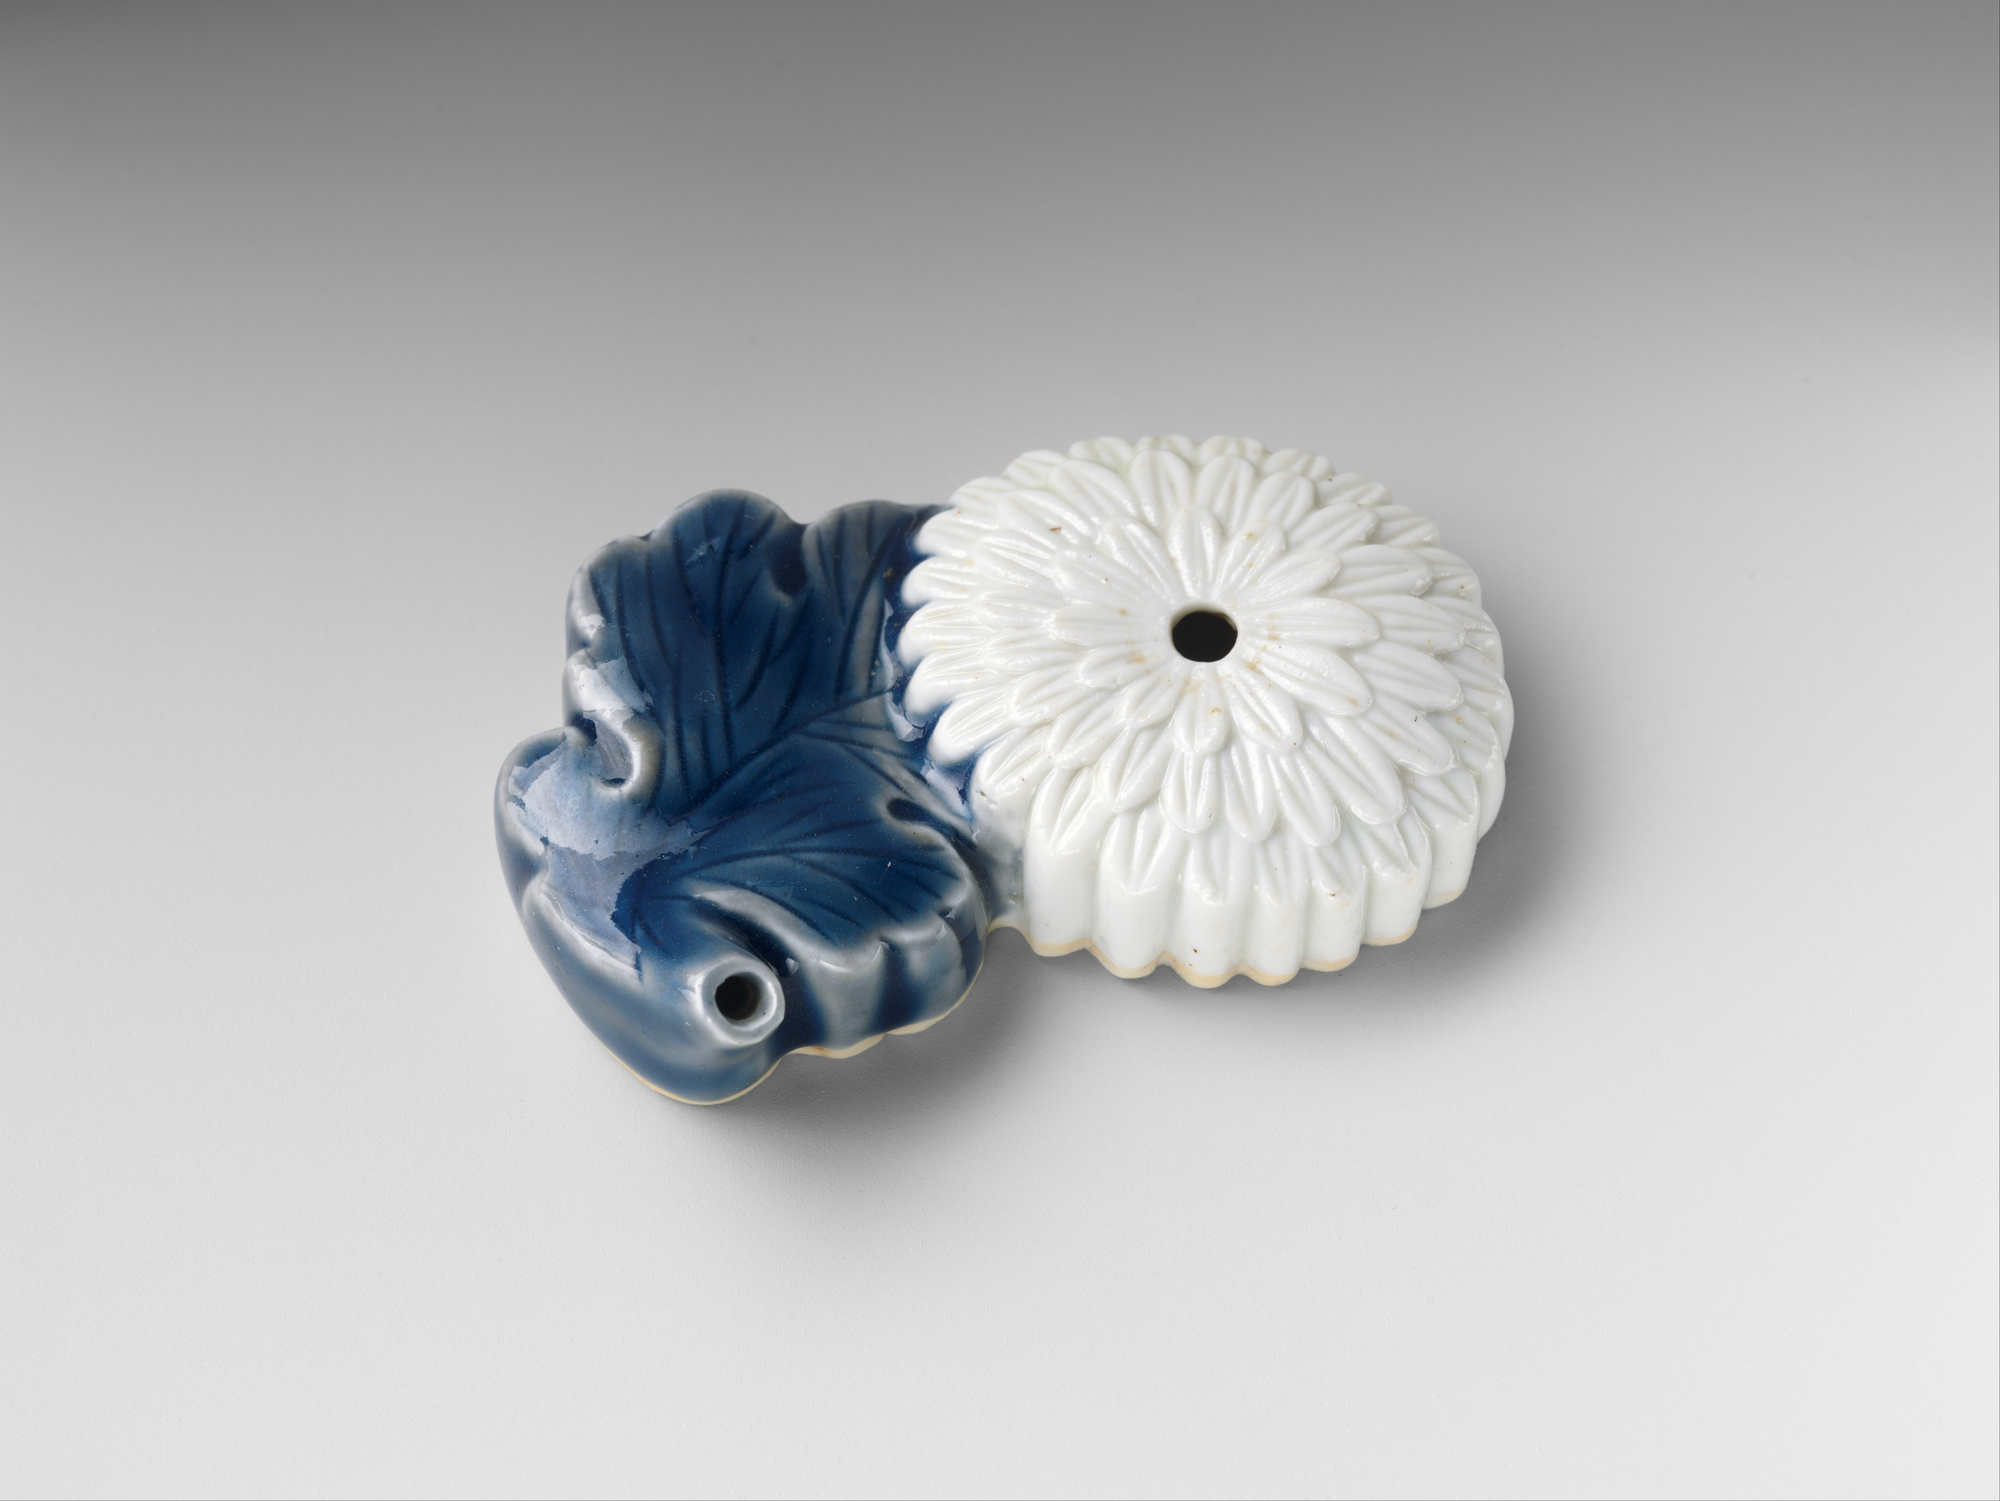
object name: water dropper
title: Water Dropper in the Shape of a Chrysanthemum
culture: japanese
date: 1801-1850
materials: cobalt, glaze, porcelain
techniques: molding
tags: flowers